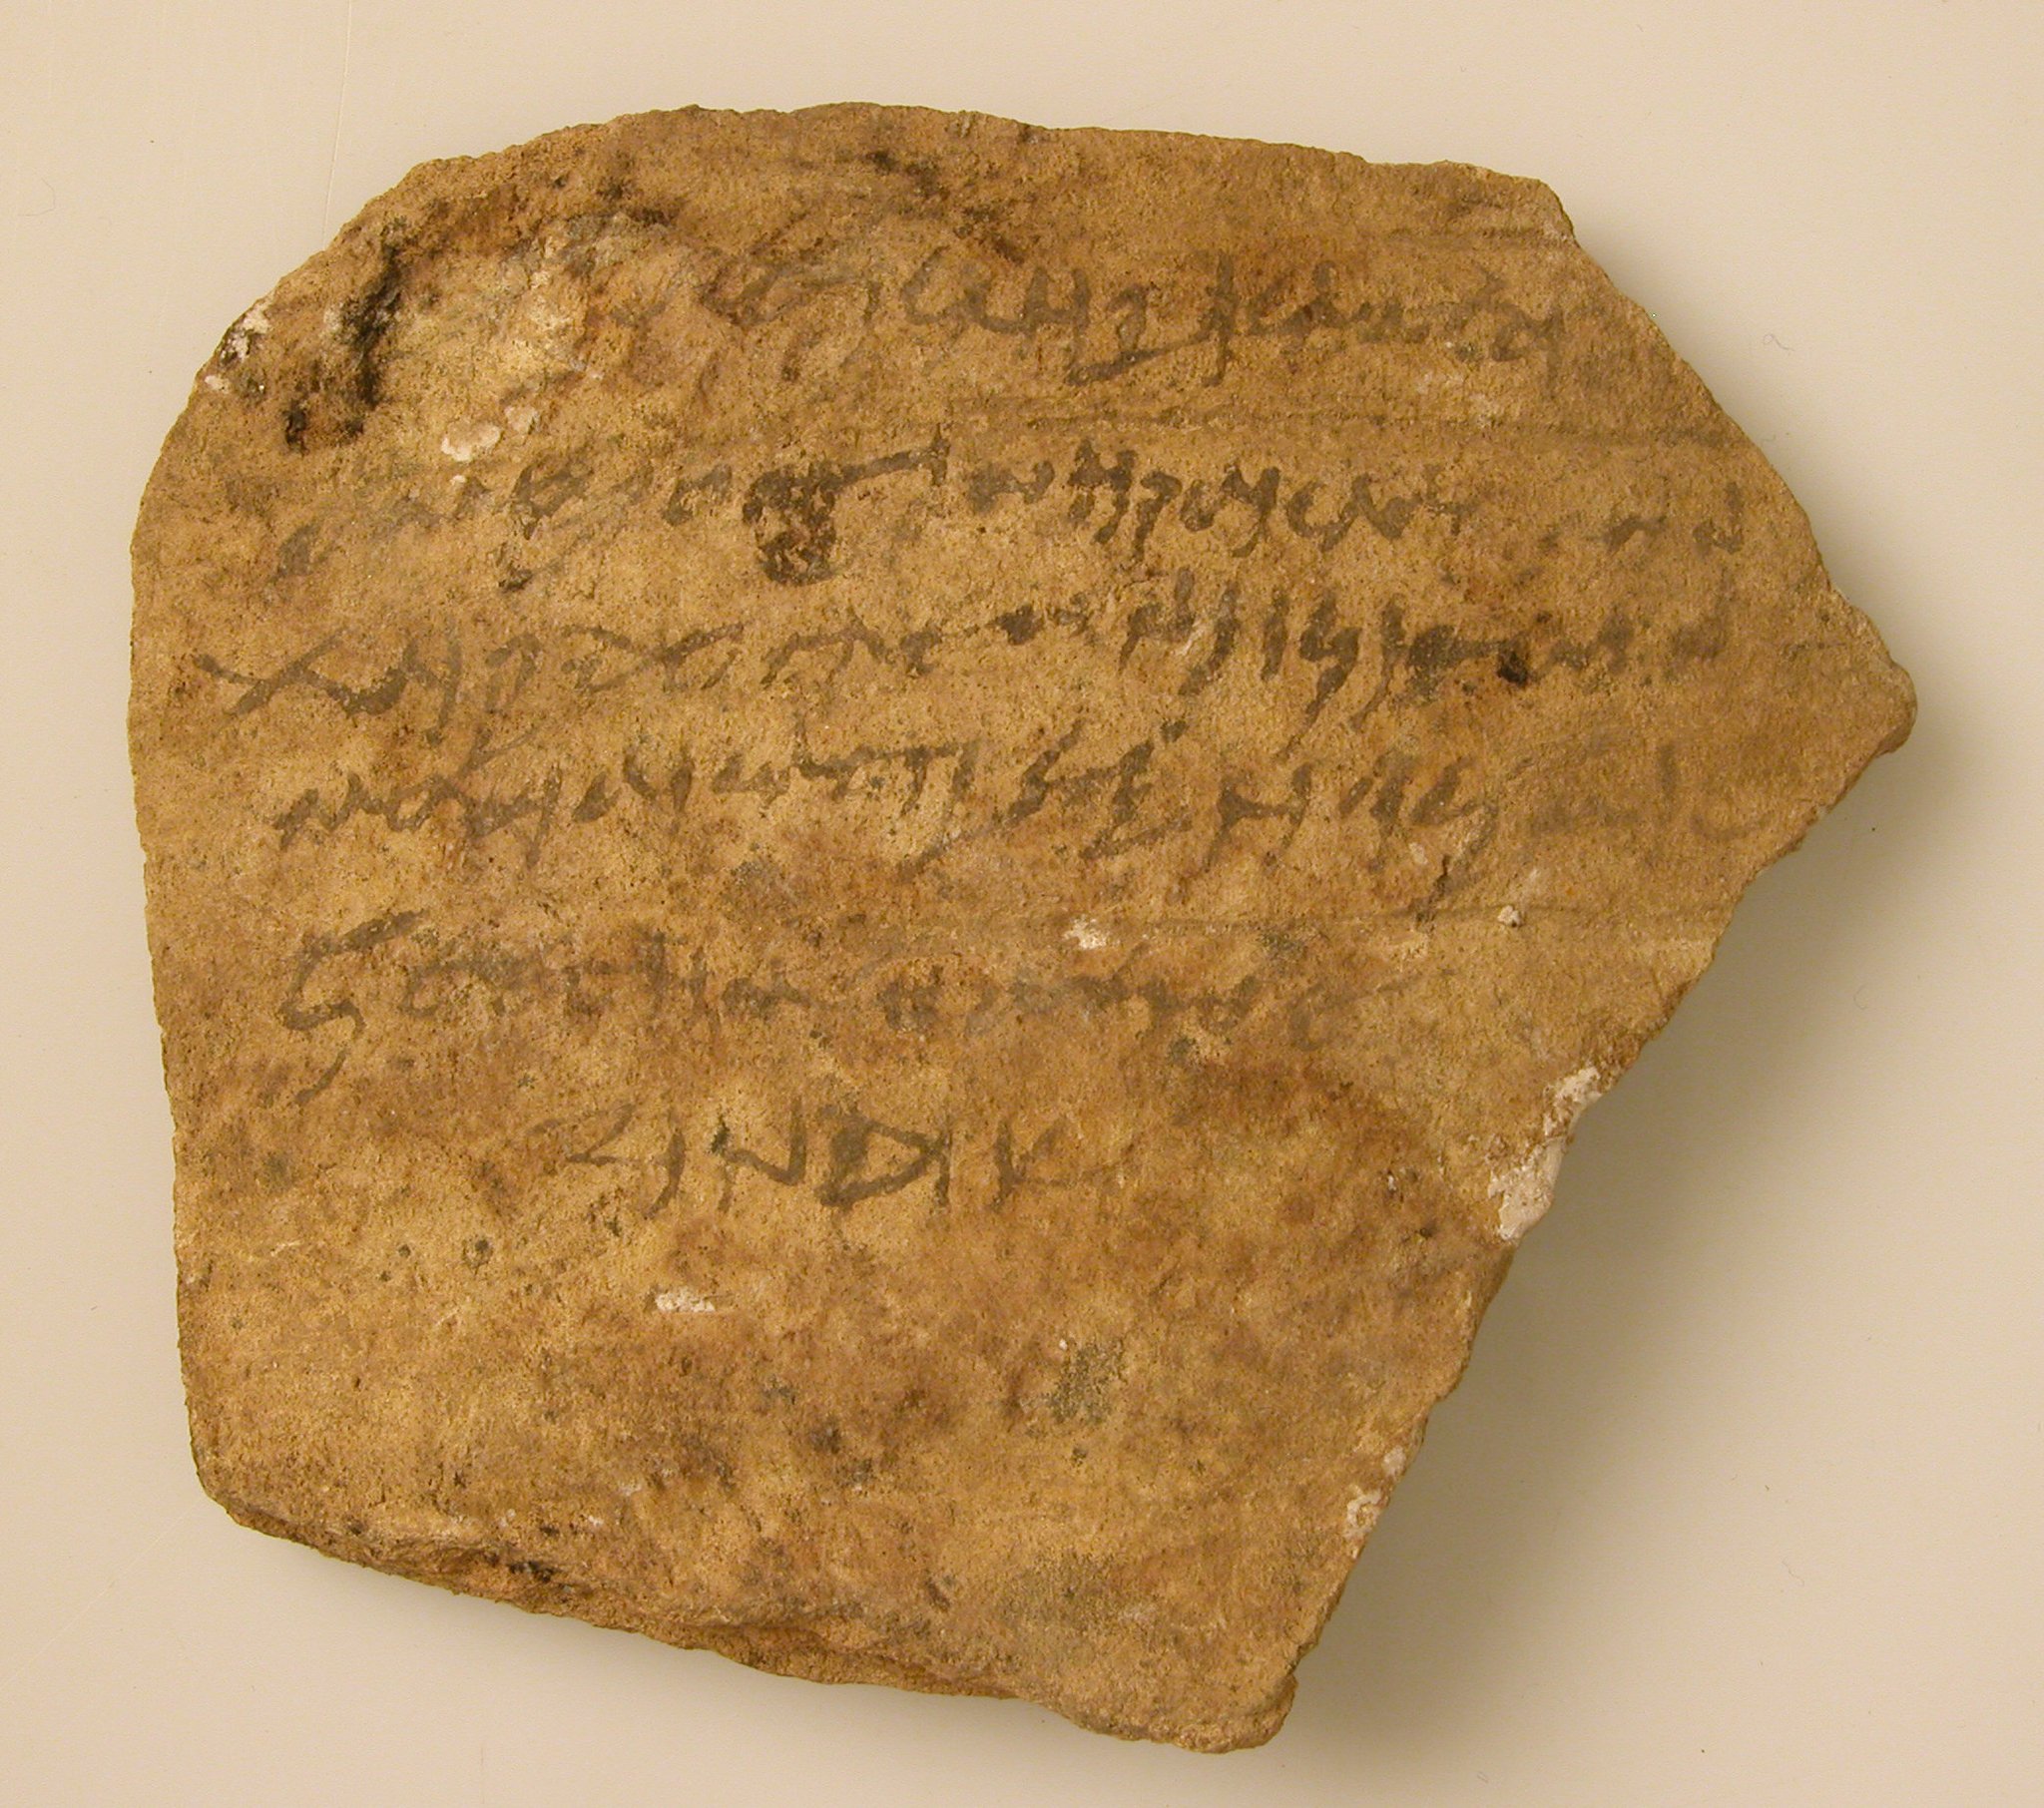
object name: ostrakon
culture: coptic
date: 301-700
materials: ink, pottery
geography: egypt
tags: documents